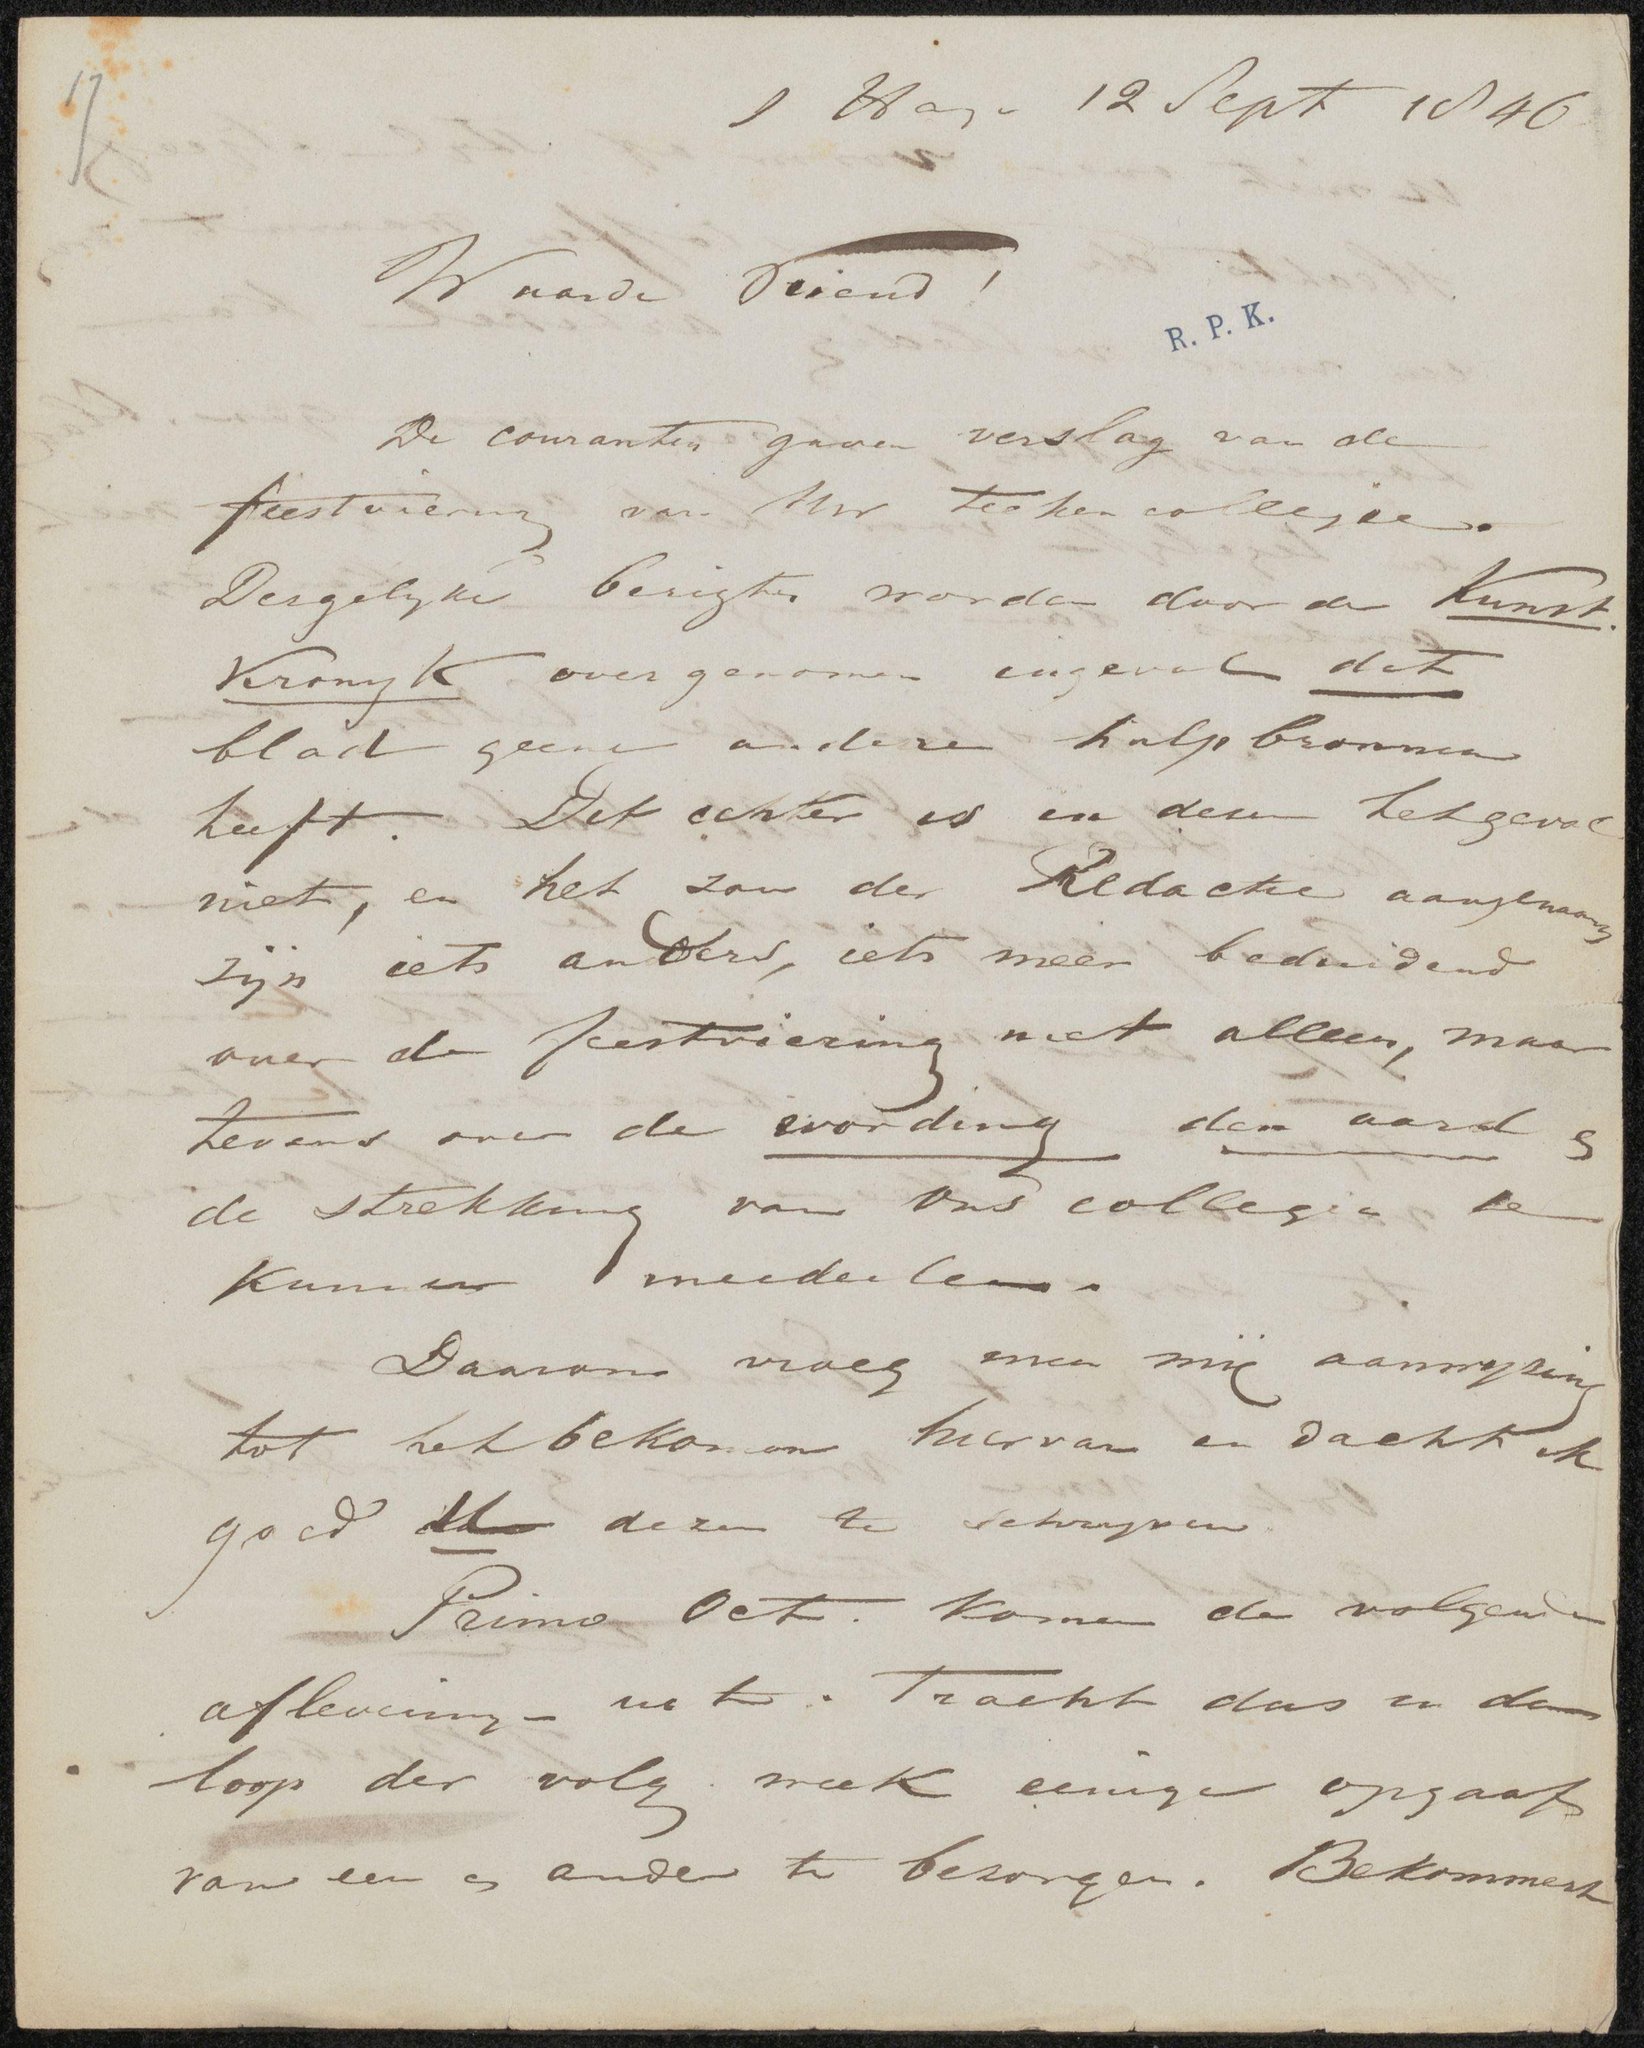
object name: letter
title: Brief aan A.B. Verpoorten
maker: johannes bosboom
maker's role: draughtsman, painter, print maker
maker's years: 1817-1891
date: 1846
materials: ink, paper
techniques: pen, writing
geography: the hague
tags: haarlem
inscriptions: collector's mark: Lugt 2233